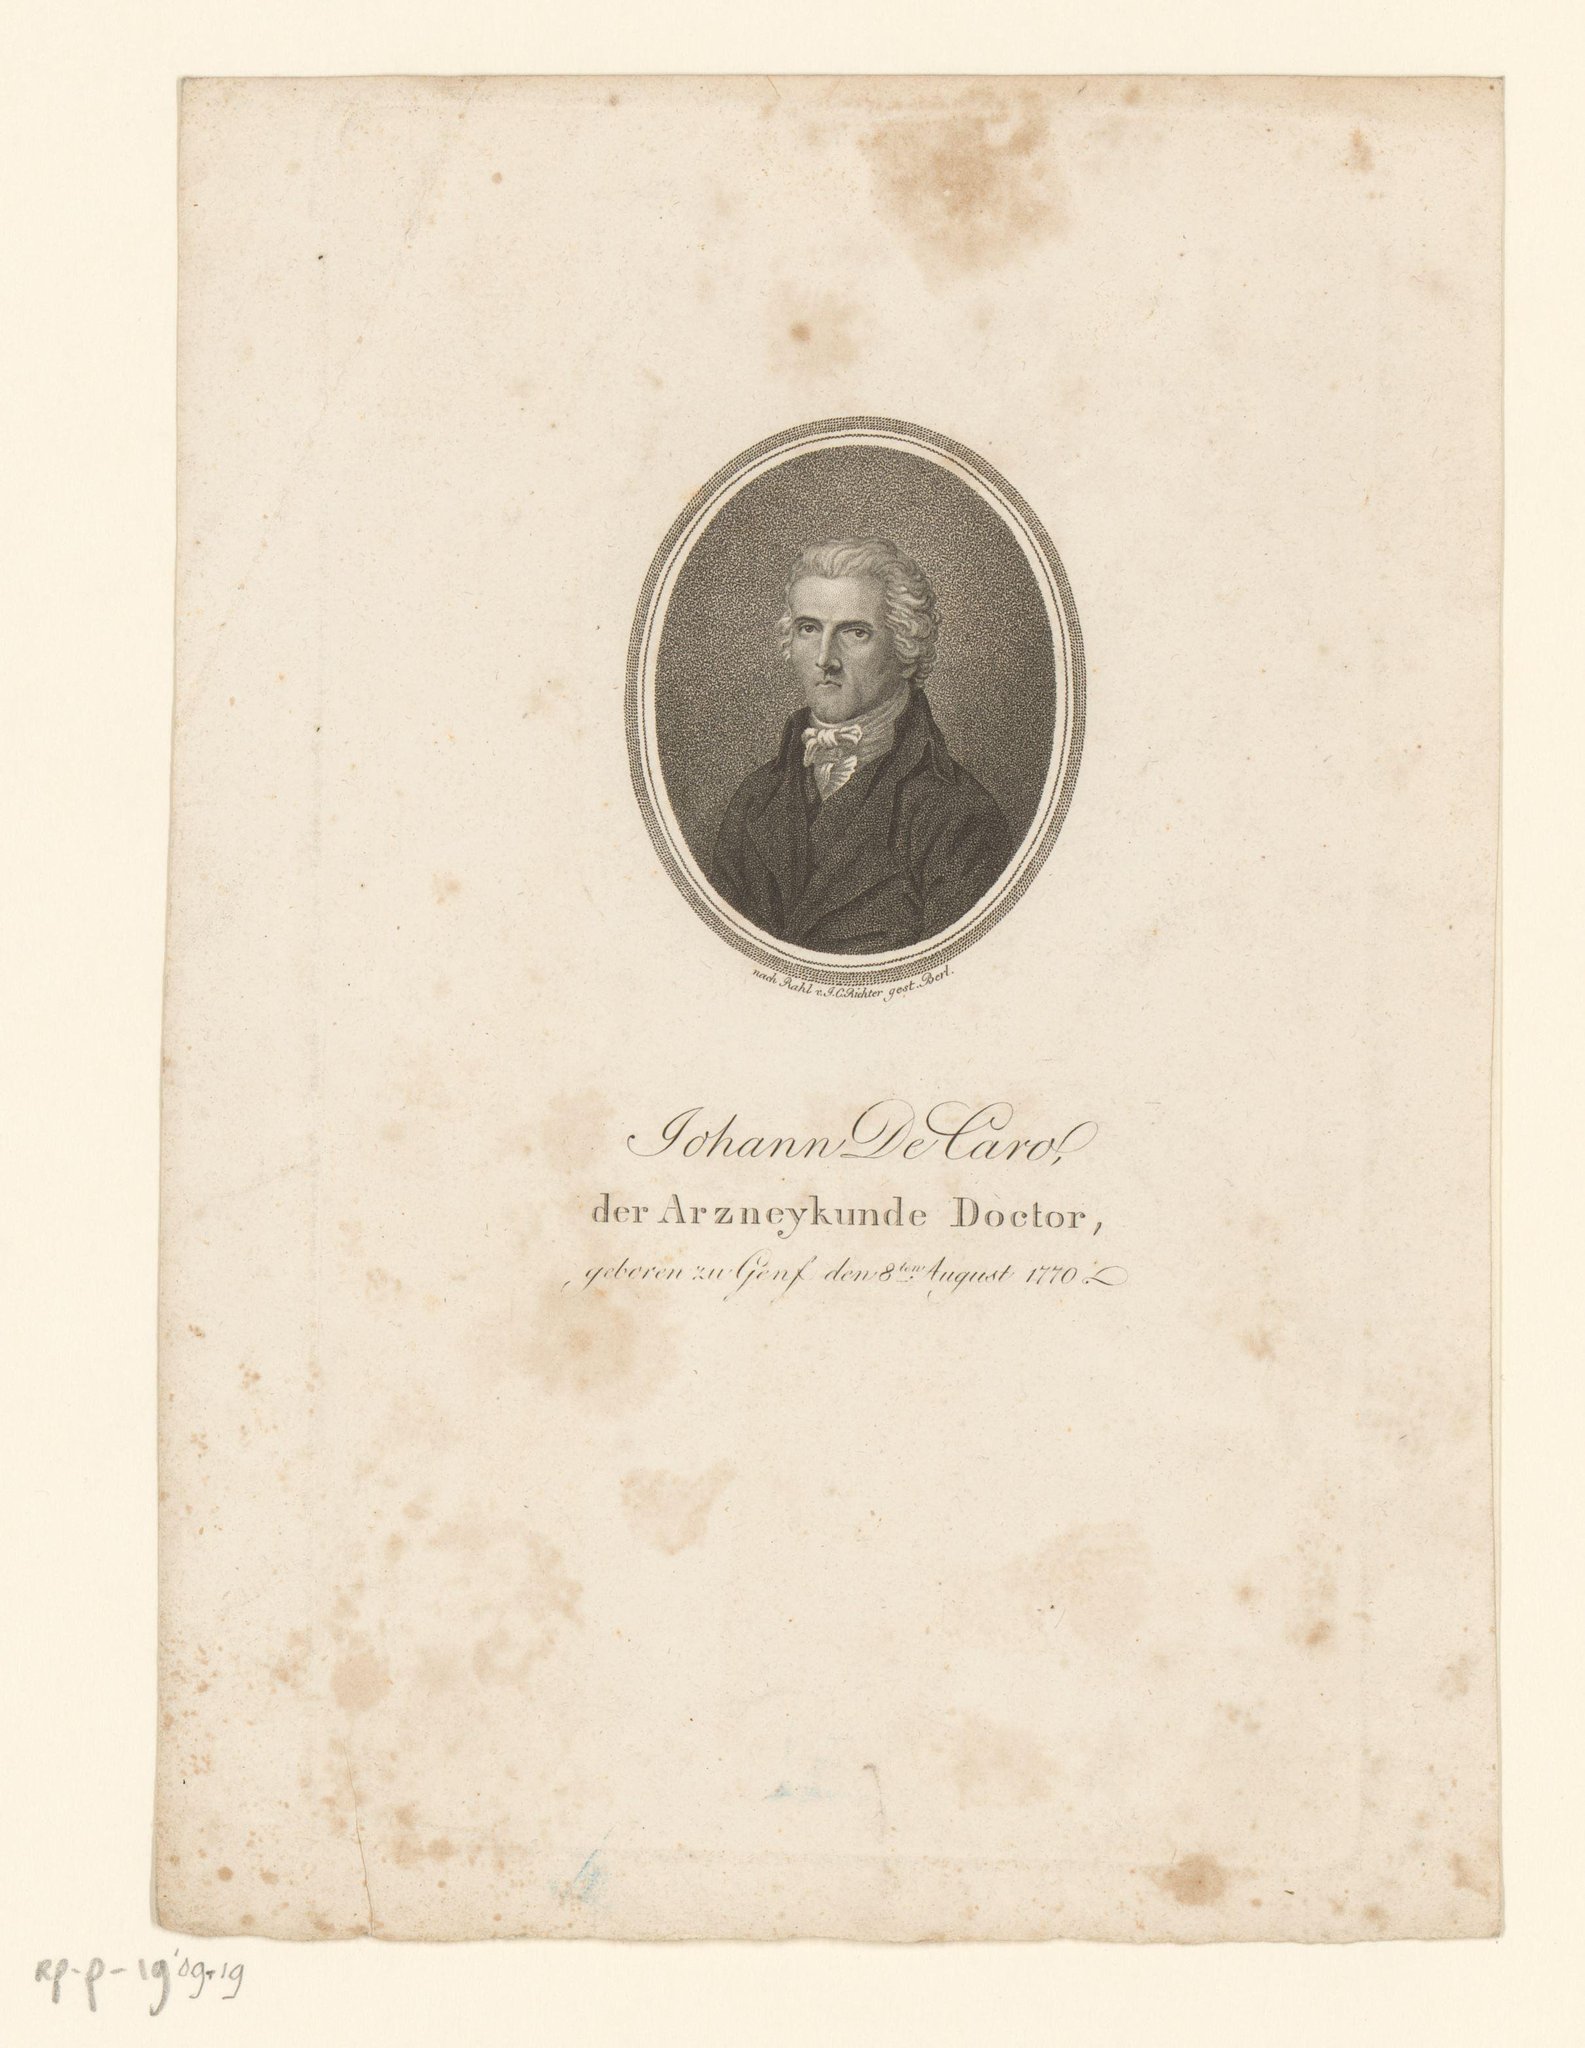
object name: print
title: Portret van Johann De Caro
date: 1780-1832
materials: paper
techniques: engraving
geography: berlin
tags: historical persons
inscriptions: collector's mark: Lugt 2228